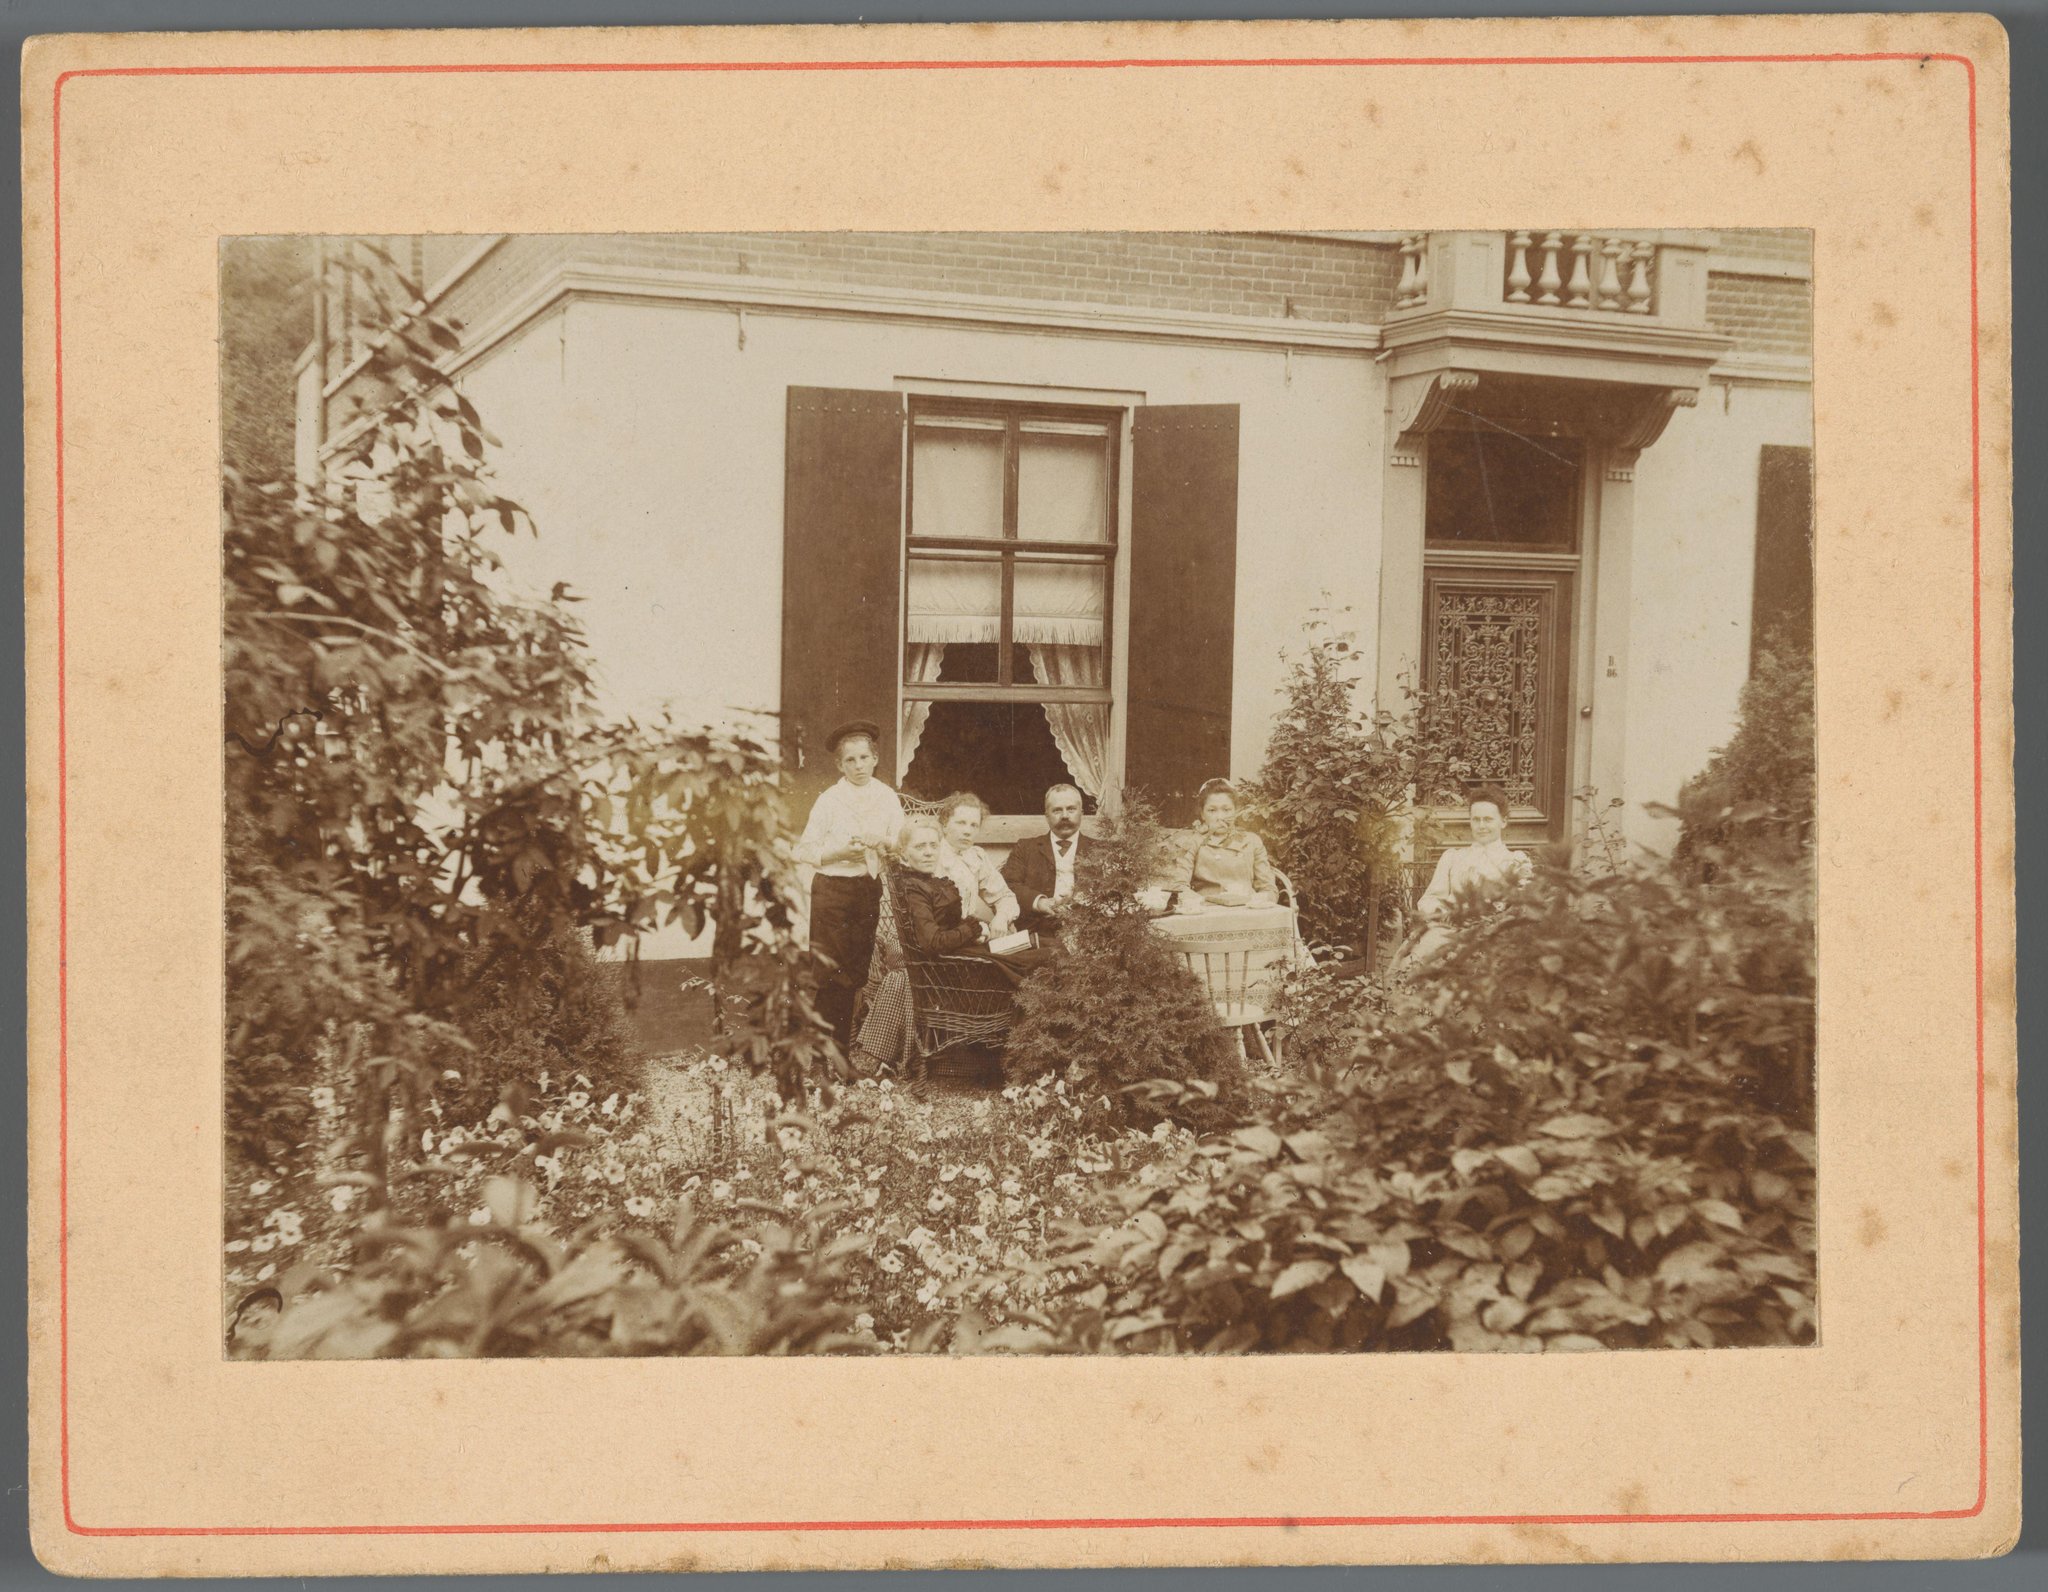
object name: photograph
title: Portret van een onbekend gezin in de tuin voor een huis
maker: Anonymous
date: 1880-1940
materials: cardboard, photographic support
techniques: collodion silver print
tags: garden, anonymous historical persons portrayed in a group, in a group-portrait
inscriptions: annotation: ‘Wrschl. Beek/ bij Nijmegen’, stamp: ‘[...]ntein [...]’